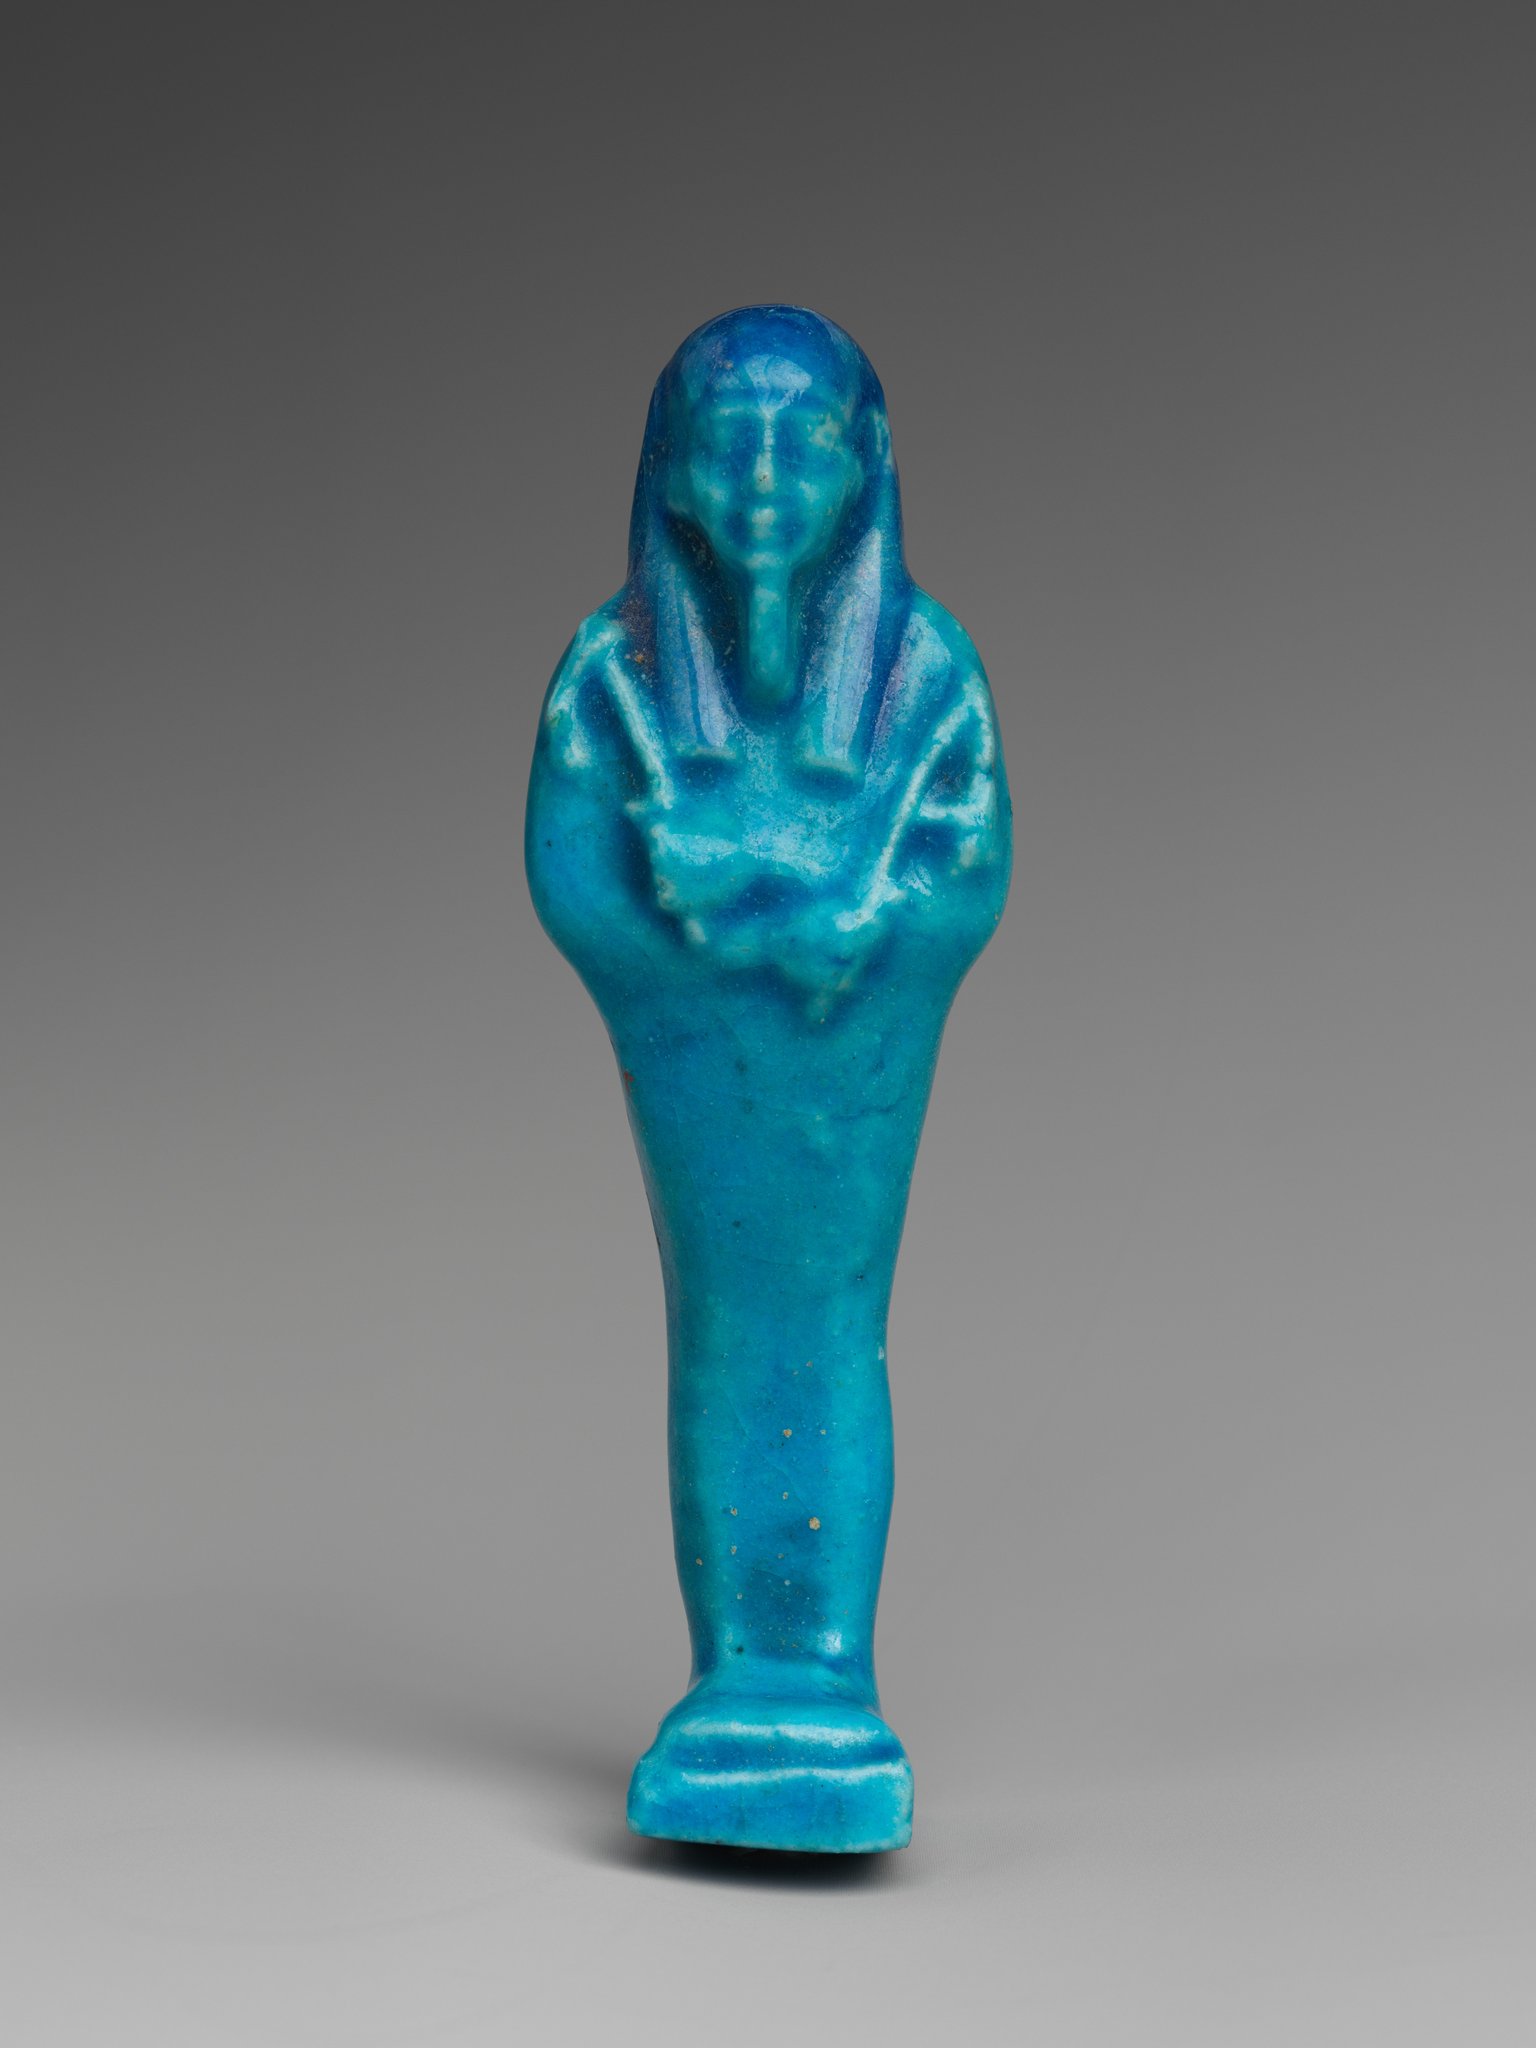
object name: shabti, petosiris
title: Shabti of Petosiris, son of Djedhor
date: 360-300 BCE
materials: faience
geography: egypt